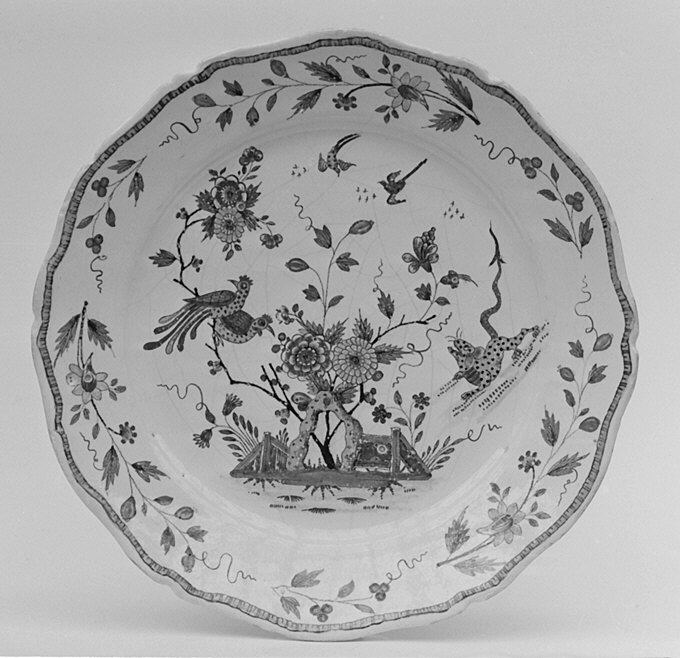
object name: plate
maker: jean-baptiste guillibaud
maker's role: factory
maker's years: 1720-1739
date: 1735-1740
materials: faience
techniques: glazing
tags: birds,flowers